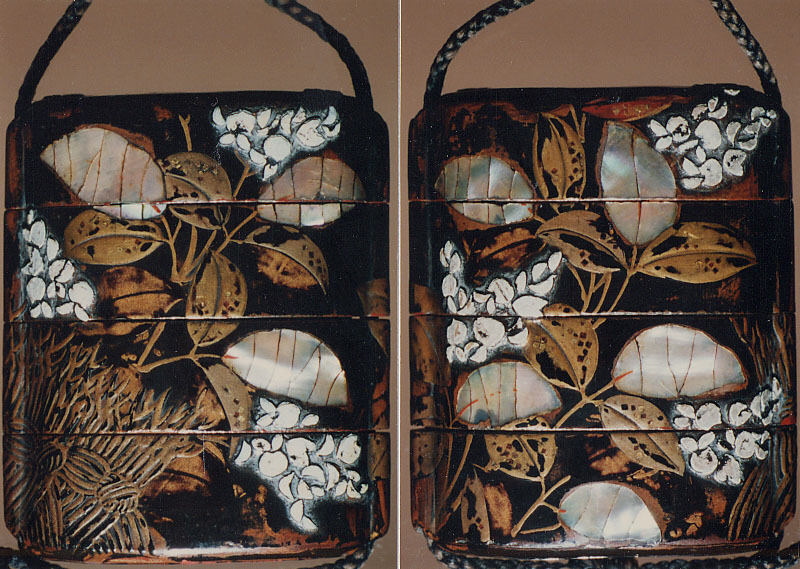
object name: inrō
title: Case (Inrō) with Design of Flowering Hagi beside a Brushwood Fence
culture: japanese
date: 1601-1800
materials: gold, lacquer, pottery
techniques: fundame, hiramakie, inlay, roiro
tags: flowers